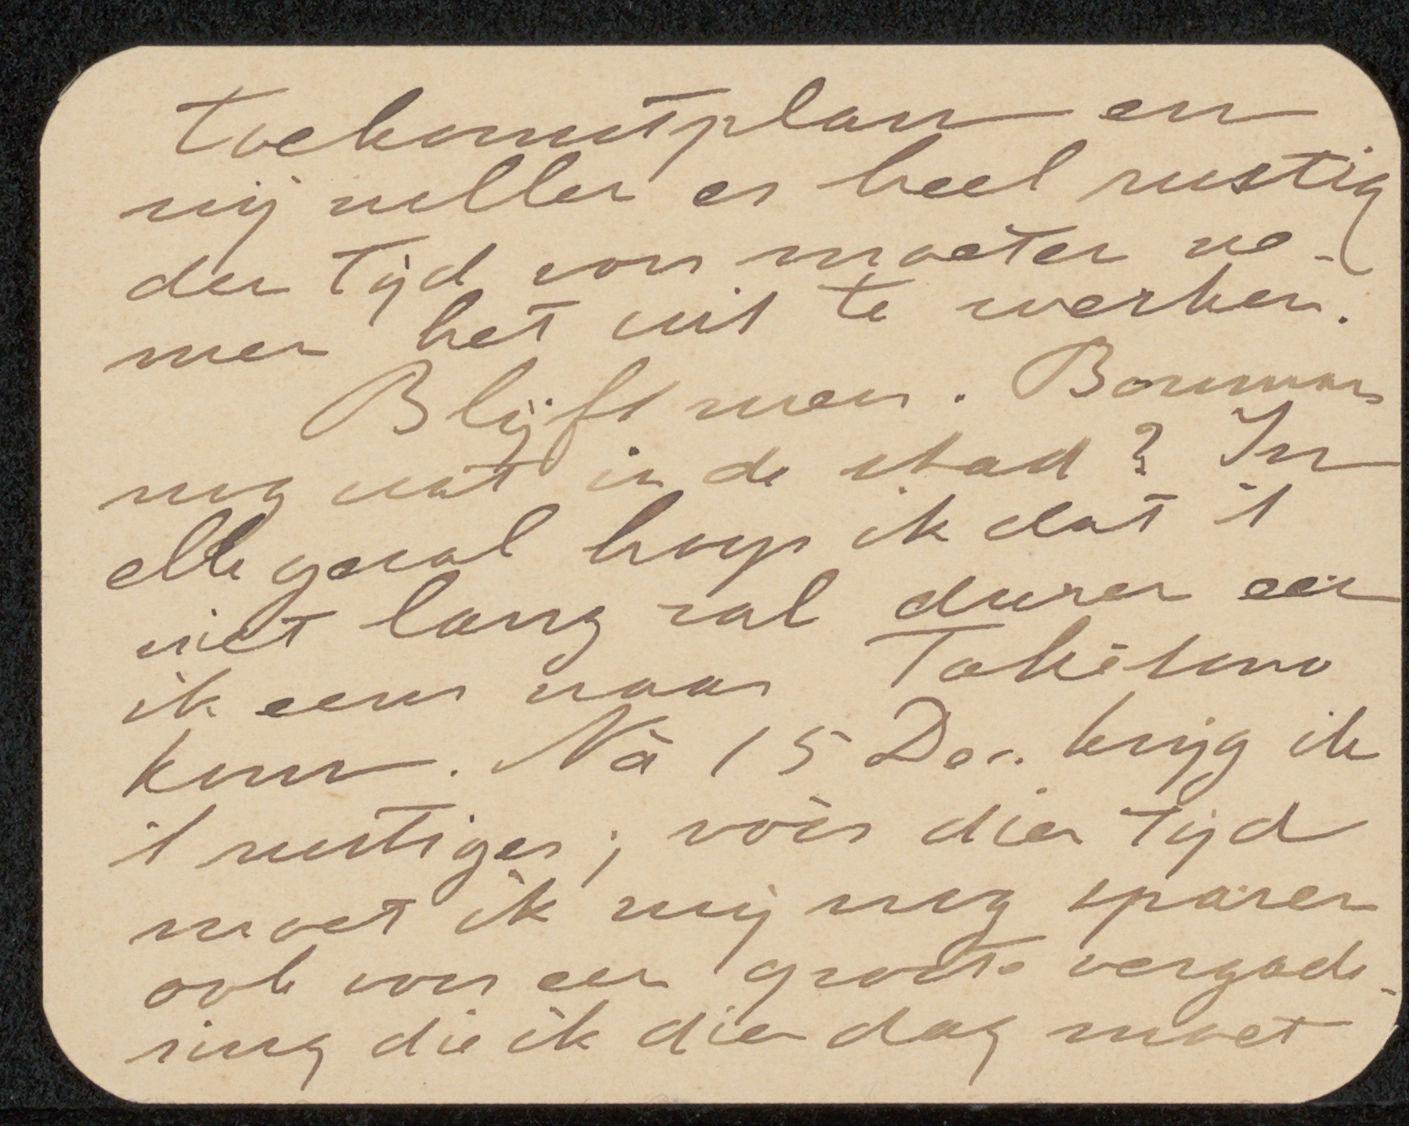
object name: letter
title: Brief aan Philip Zilcken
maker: suze groshans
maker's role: schrijver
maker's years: 1863-1944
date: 1926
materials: cardboard, ink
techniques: pen, writing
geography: the hague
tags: painter, draughtsman, philip zilcken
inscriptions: collector's mark: ‘RPK’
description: Vormt samen met RP-D-1982-43-GROSHANS(SUZE)-5B een doorlopende brief.